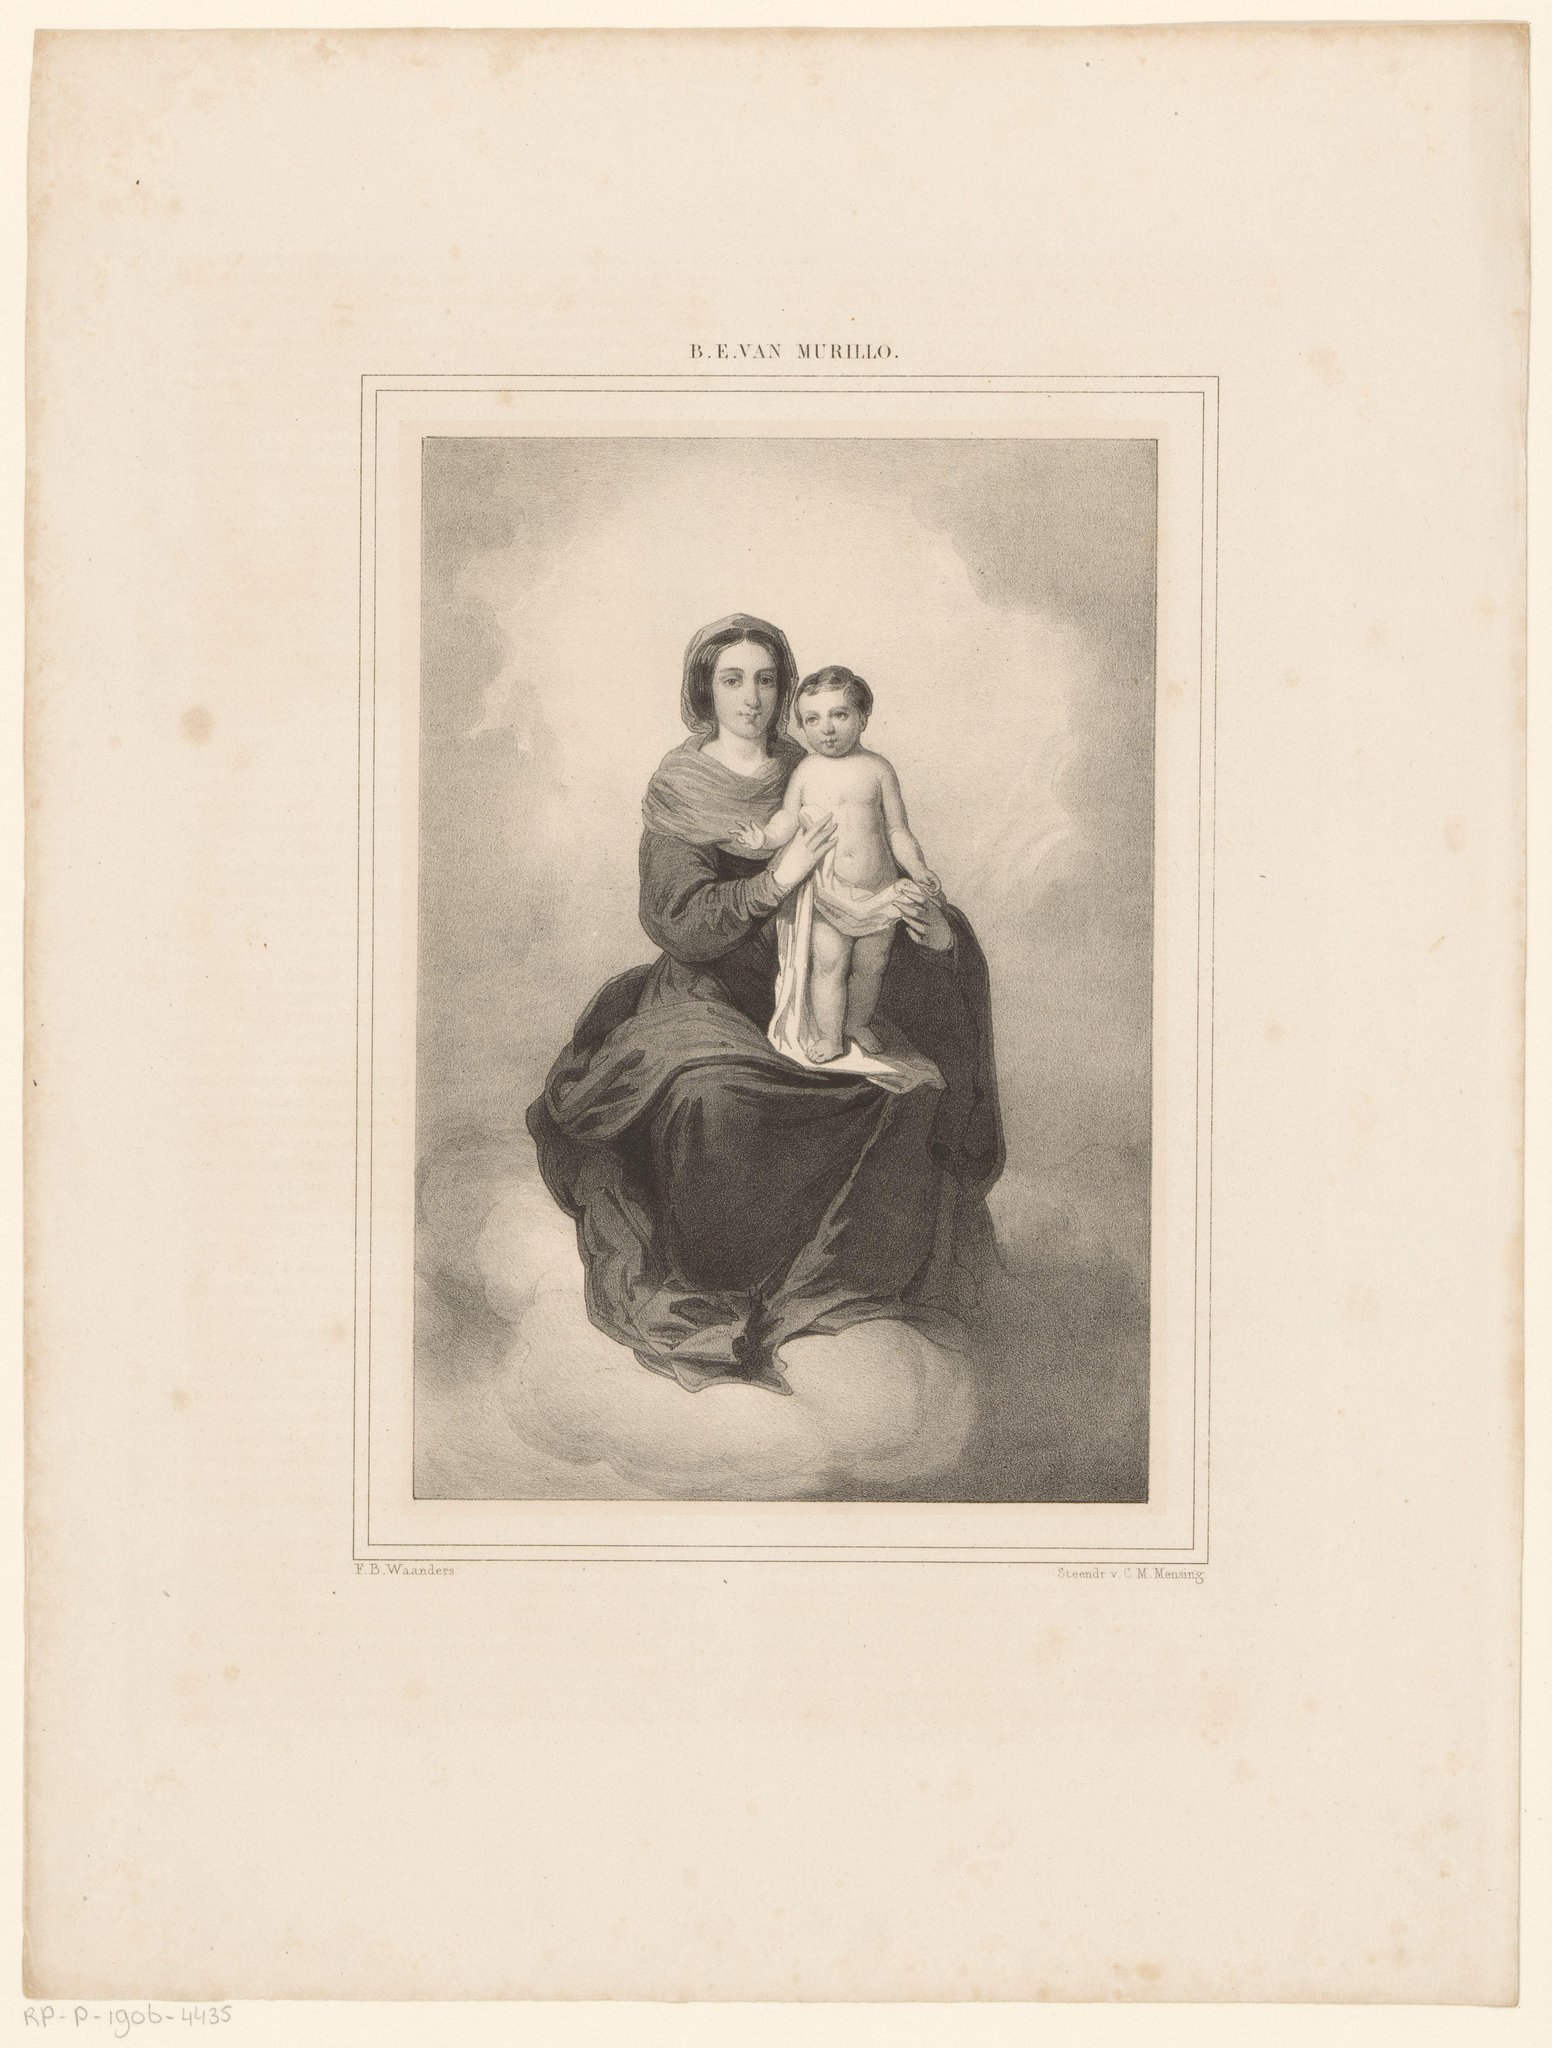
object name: print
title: Maria met kind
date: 1847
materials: paper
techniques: lithograph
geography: the hague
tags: madonna: i.e. mary with the christ-child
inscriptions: collector's mark: Lugt 2228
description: Maria, gezeten op de wolken, houdt met beide handen het Christuskind vast, dat op haar schoot staat.